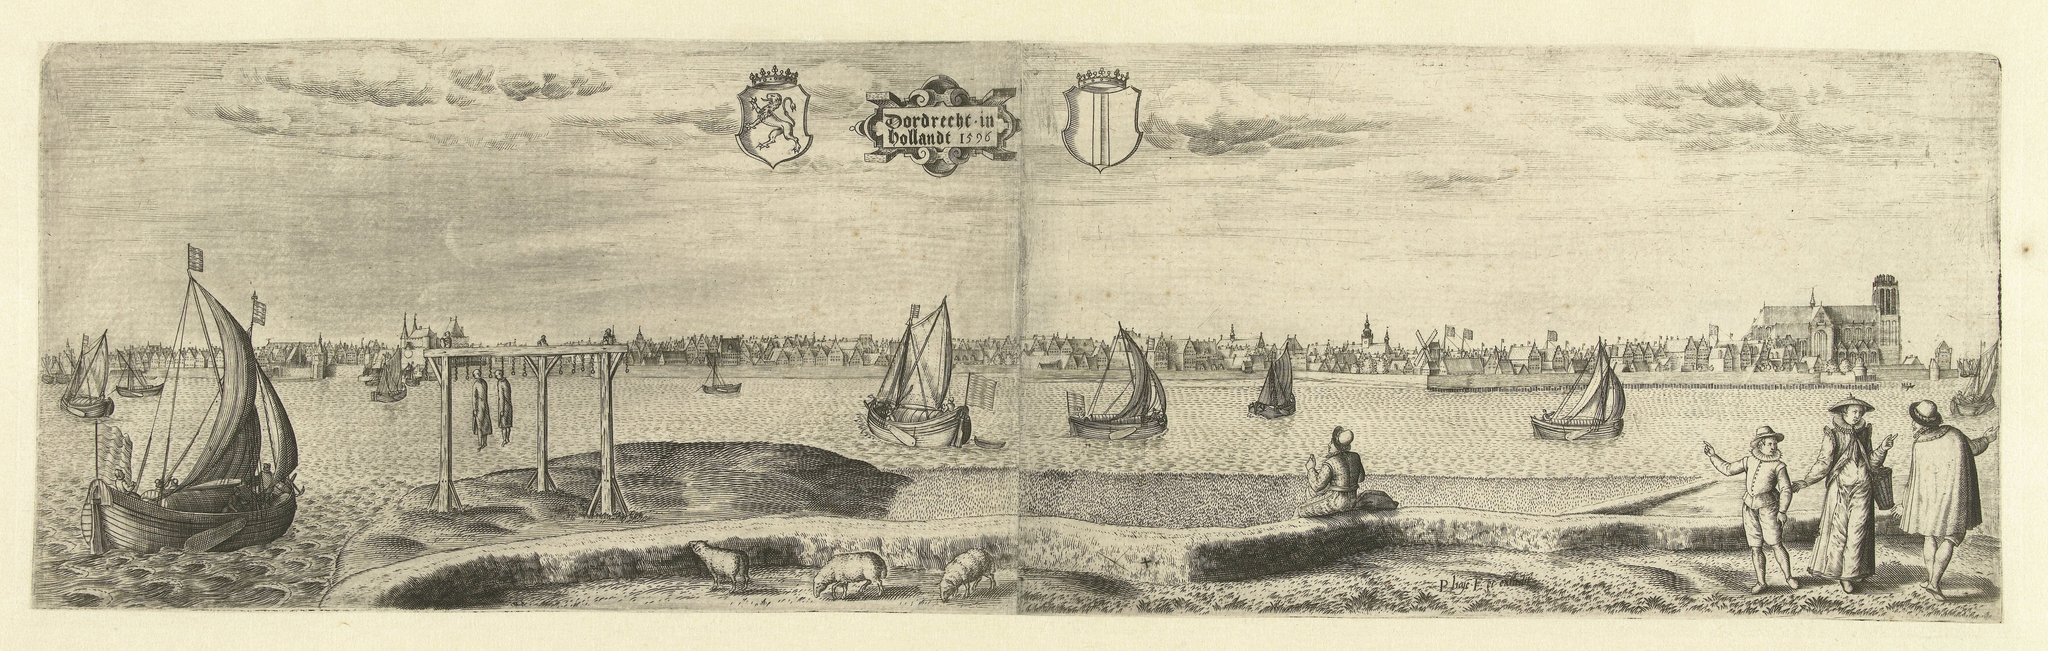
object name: print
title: Dordrecht in Hollandt 1596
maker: pieter bast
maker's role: print maker, publisher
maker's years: 1570-1605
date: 1596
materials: paper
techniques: engraving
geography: northern netherlands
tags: body of the executed displayed in public, dordrecht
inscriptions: collector's mark: Lugt 2760, collector's mark: Lugt 2228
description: Gezicht op Dordrecht vanuit de overkant van het water. Op de voorgrond zijn een aantal personen te zien, links staat een galg met twee lichamen eraan. Rechts achter de Grote Kerk van Dordrecht. In het midden een cartouche met de naam van de stad, links het wapen van Zuid-Holland en rechts het wapen van Dordrecht.